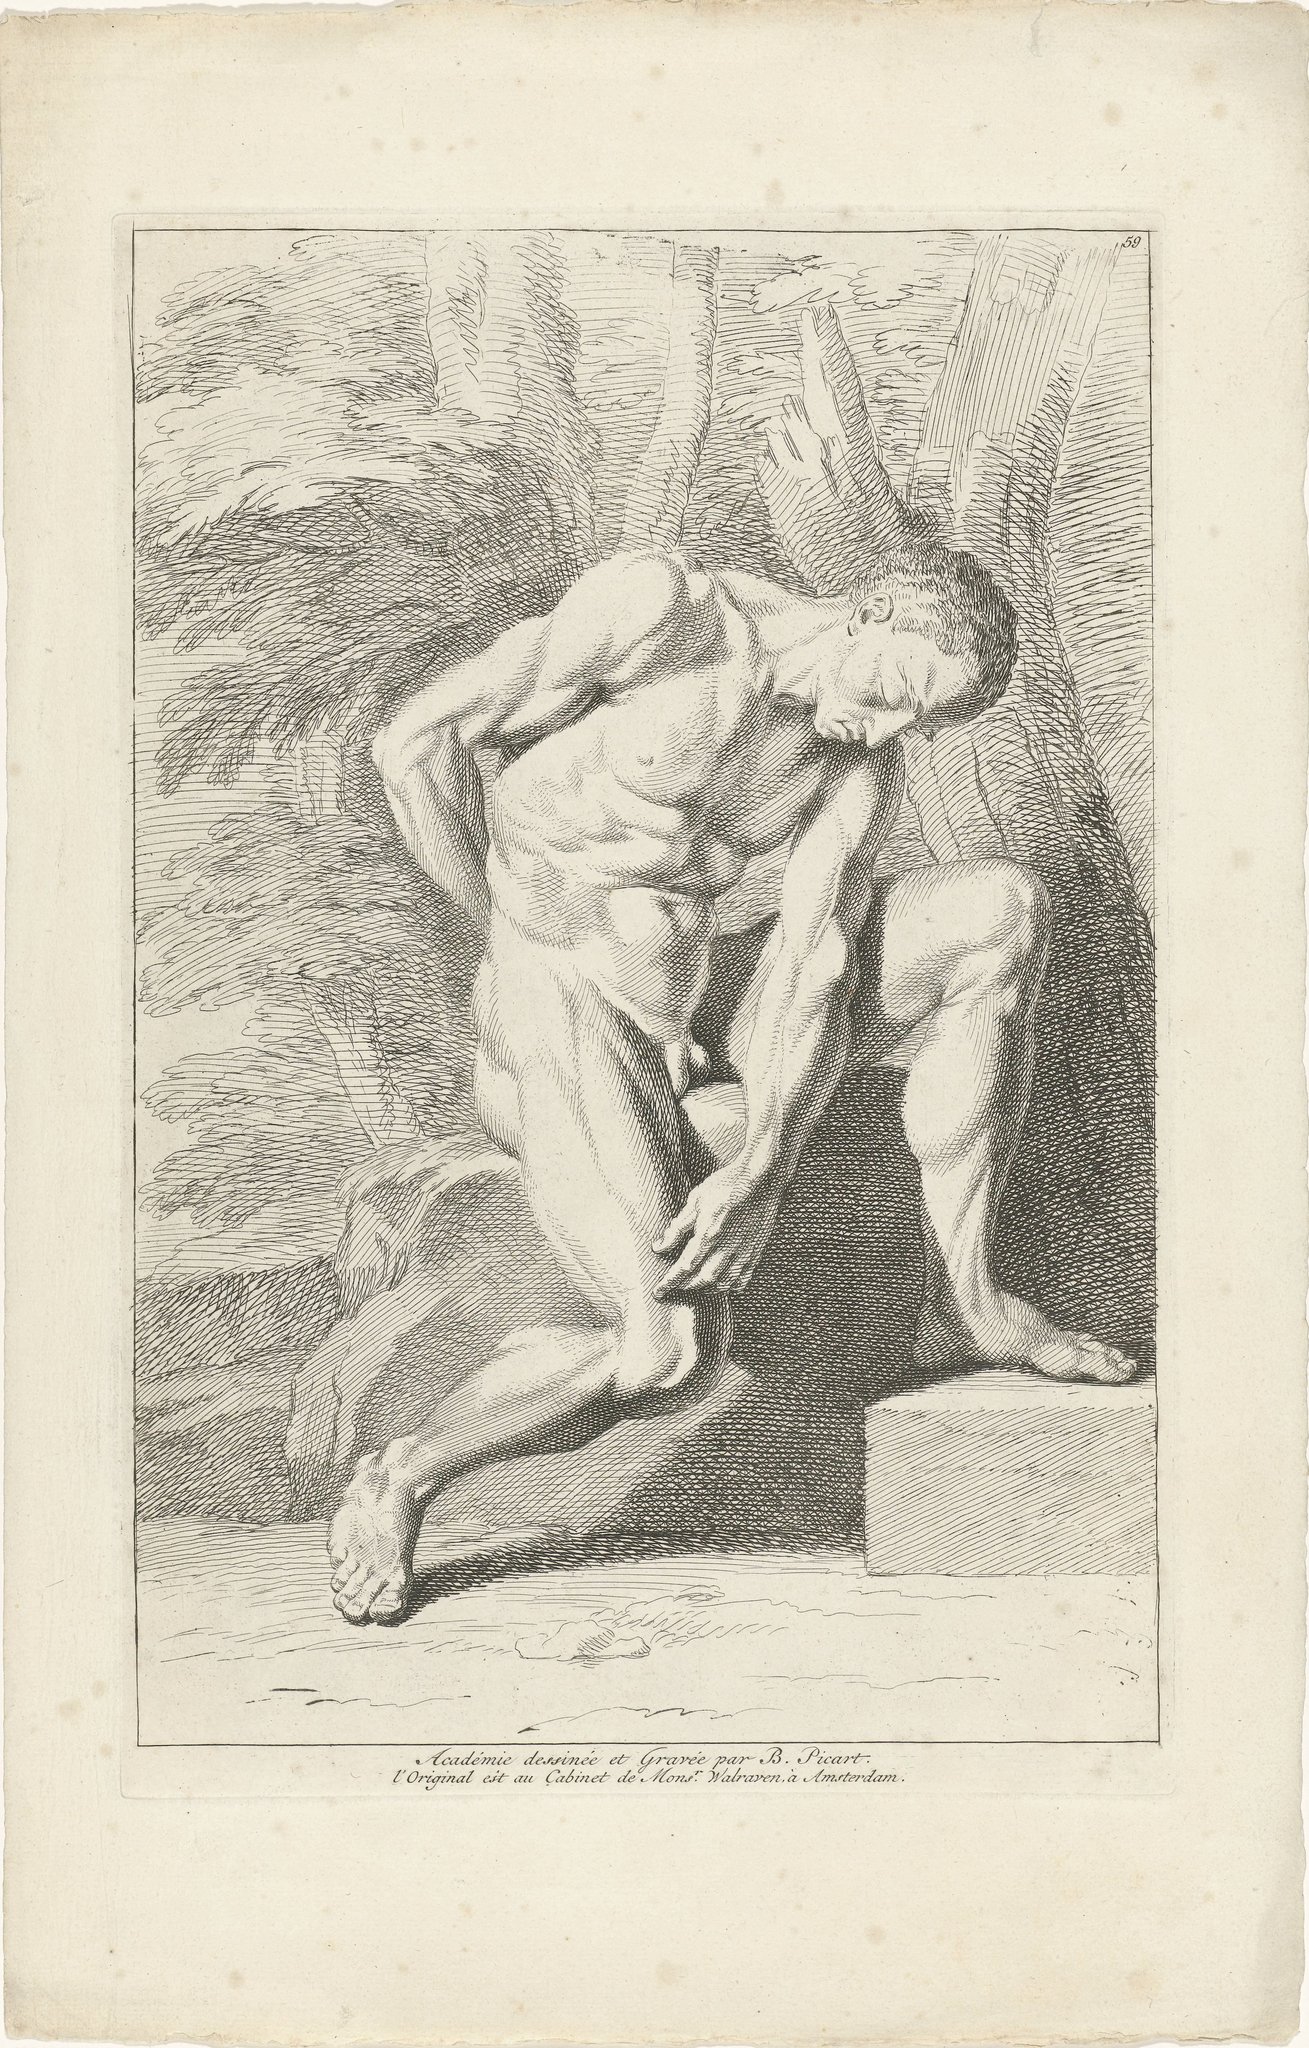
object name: print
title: Naakte man in landschap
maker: bernard picart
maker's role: draughtsman, print maker, publisher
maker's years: 1673-1733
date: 1734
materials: paper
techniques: engraving, etching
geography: amsterdam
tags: male sex; man (+ sitting)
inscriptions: collector's mark: Lugt 2233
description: Prent is ook opgenomen in: Impostures innocentes, ou recueil d'estampes d'apres divers peintres (...) par Bernard Picart (...) avec son elogue historique et le catalogue de ses ouvrages. Amsterdam: weduwe Bernard Picart, 1734.